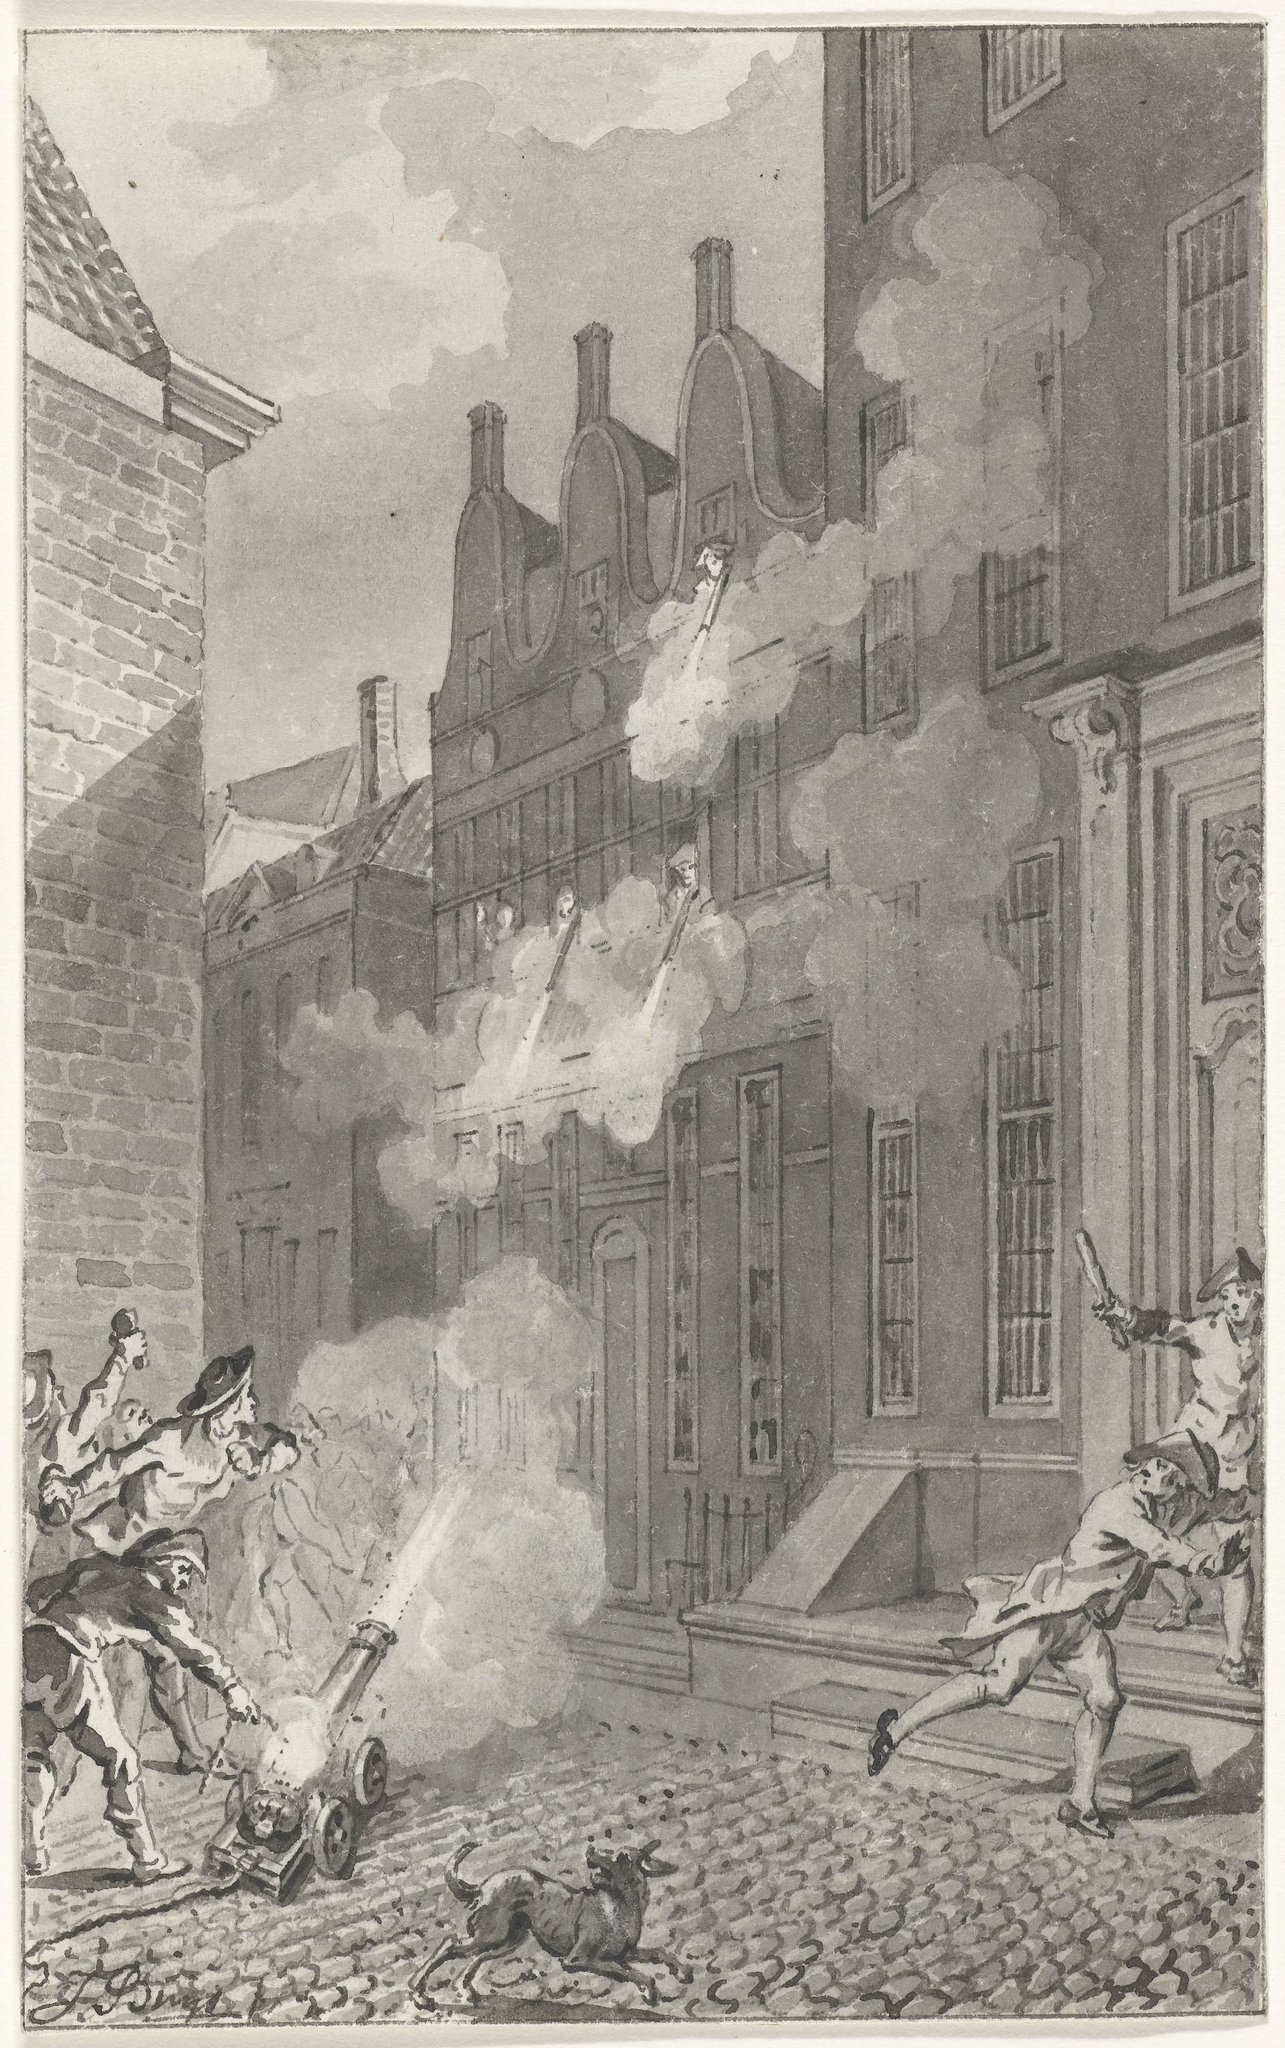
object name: drawing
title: Het beschieten met kanonnen van het huis Leeuwenburg van Dr. Lucas van Steveninck te Middelburg in de nacht van 30 juni op 1 juli 1787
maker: jacobus buys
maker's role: draughtsman, print maker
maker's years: 1724-1801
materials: ink, paper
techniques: brush, pen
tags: amsterdam, historical persons, historical events and situations